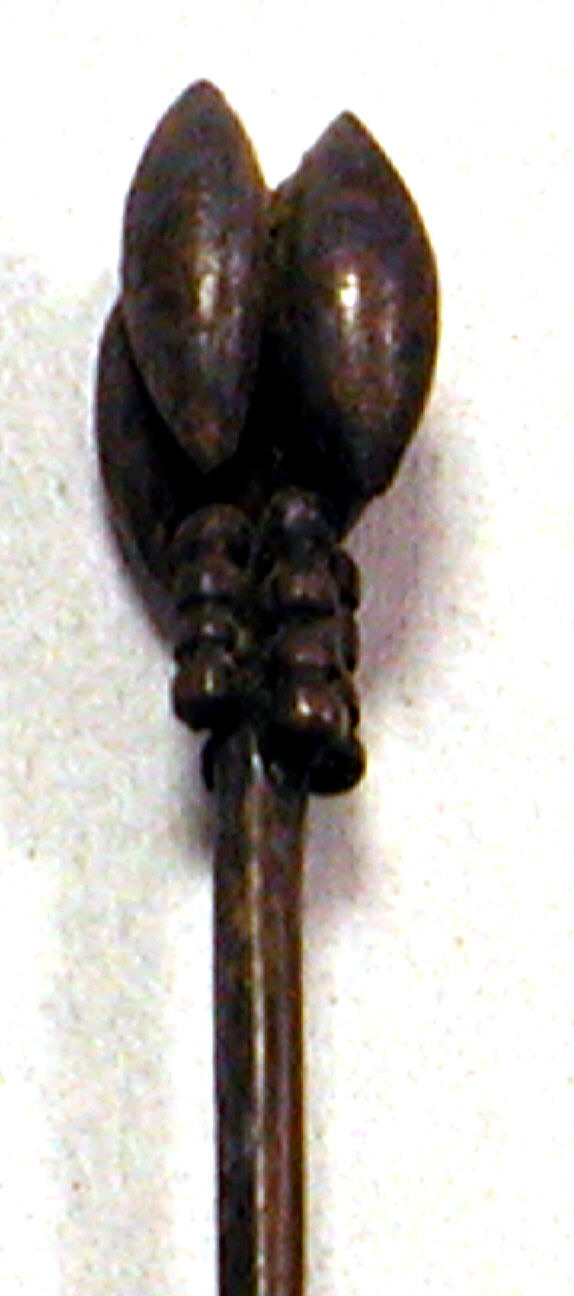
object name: pin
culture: inca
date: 1401-1600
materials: silver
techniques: hammering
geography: peru